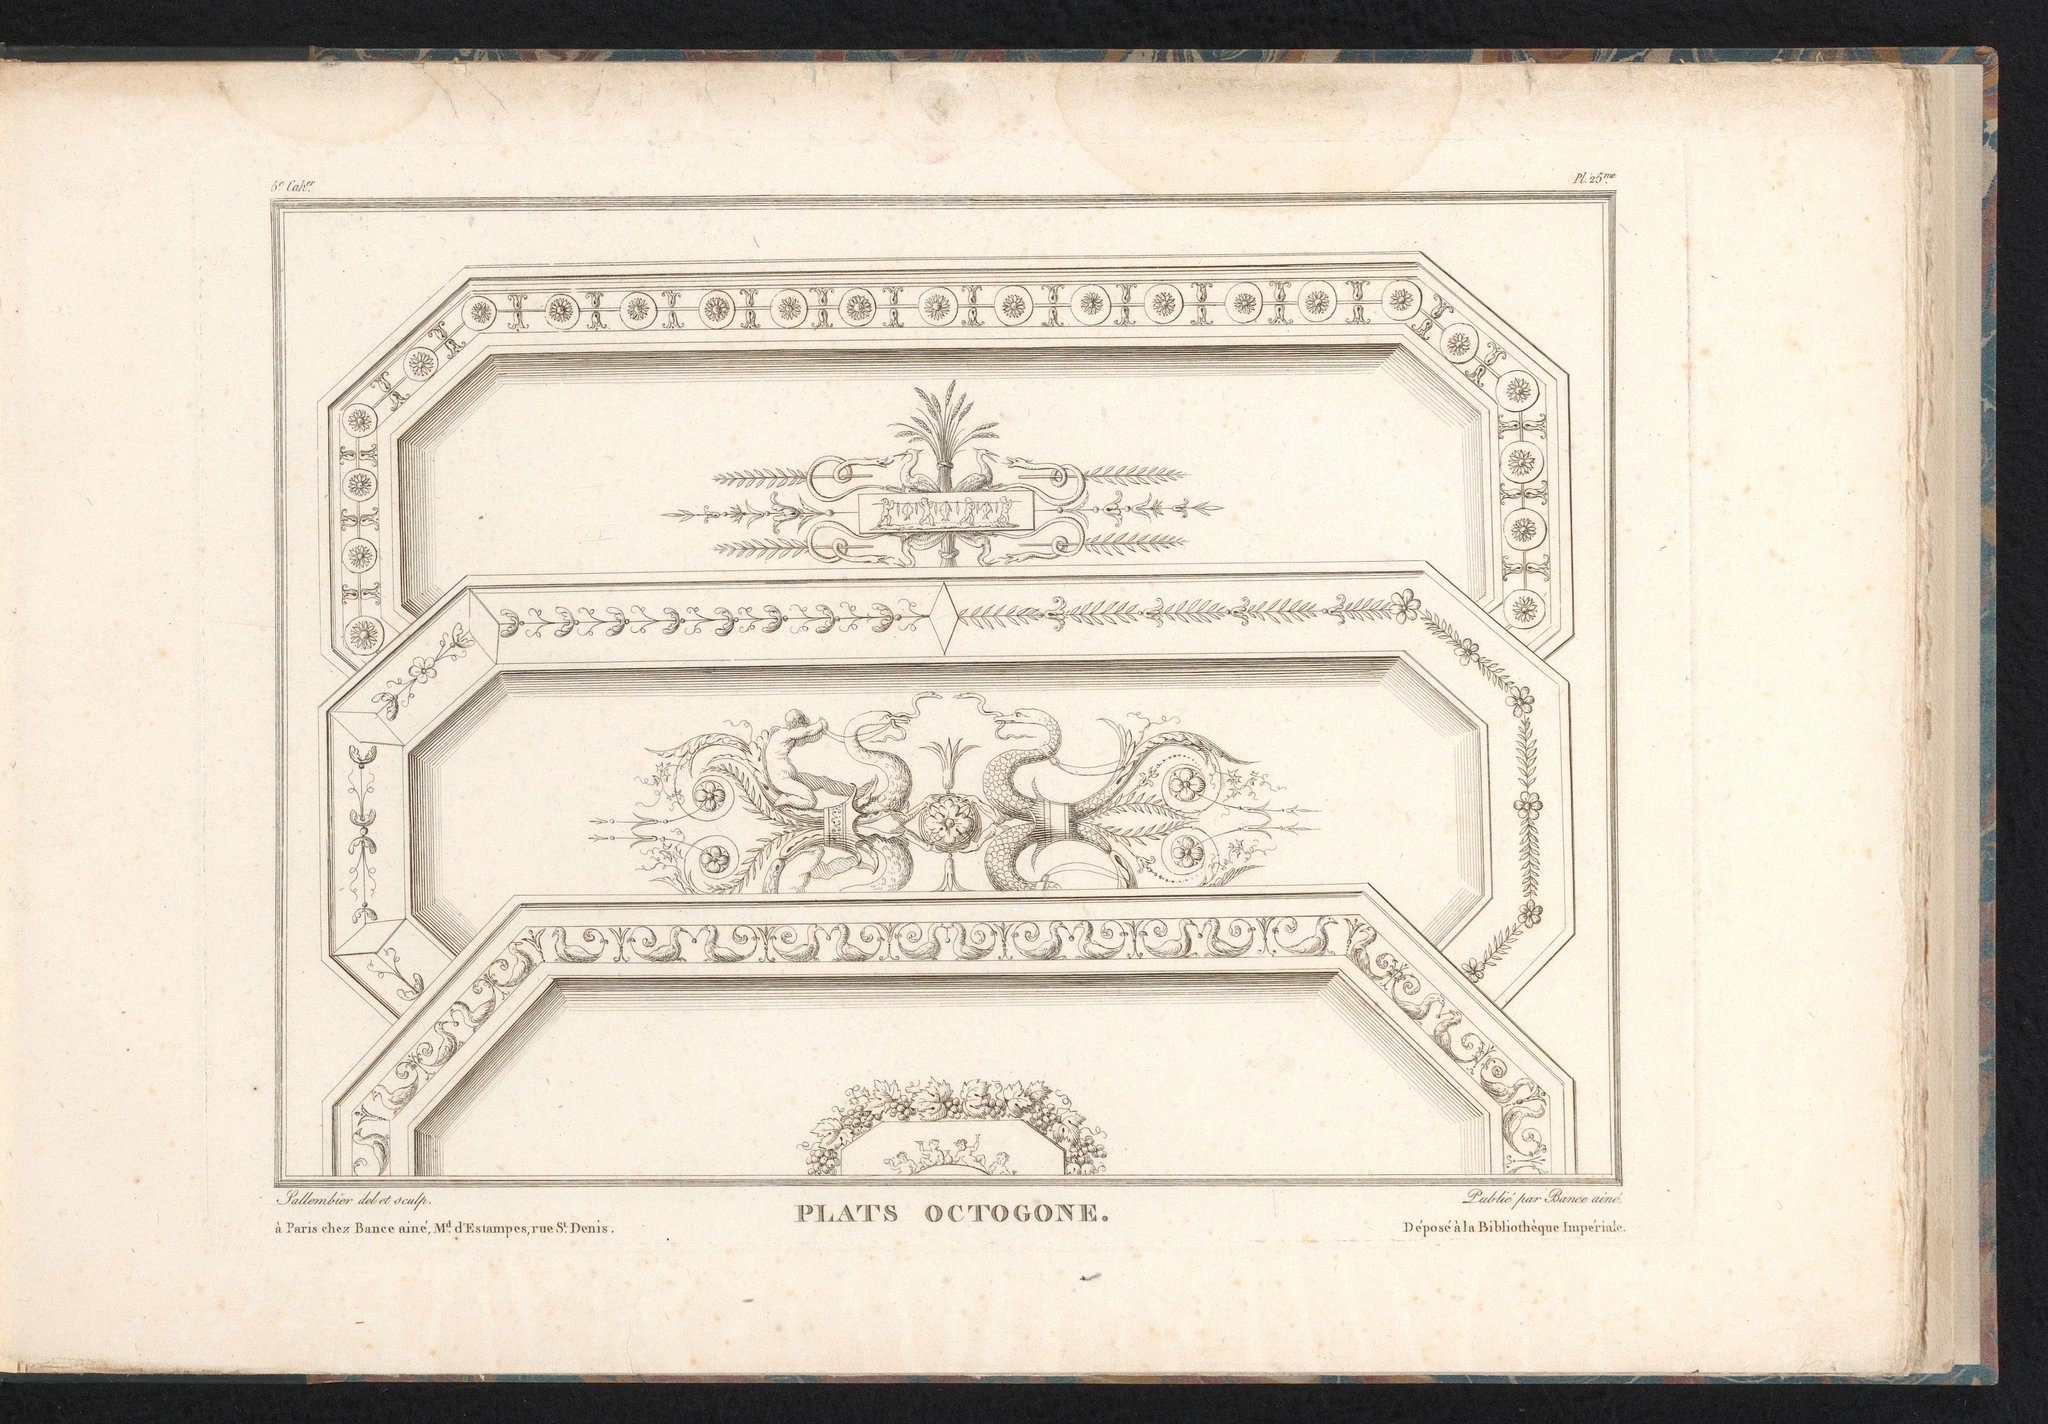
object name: album leaf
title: Modèles d'Orfèvrerie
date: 1805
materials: paper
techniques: etching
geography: paris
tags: dish, plate, saucer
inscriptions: number: ‘5.e Cah.er’, : ‘Déposé à la Bibliothèque Impériale’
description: Ontwerpen voor drie platte achthoekige schalen of borden. Prent maakt deel uit van een album.